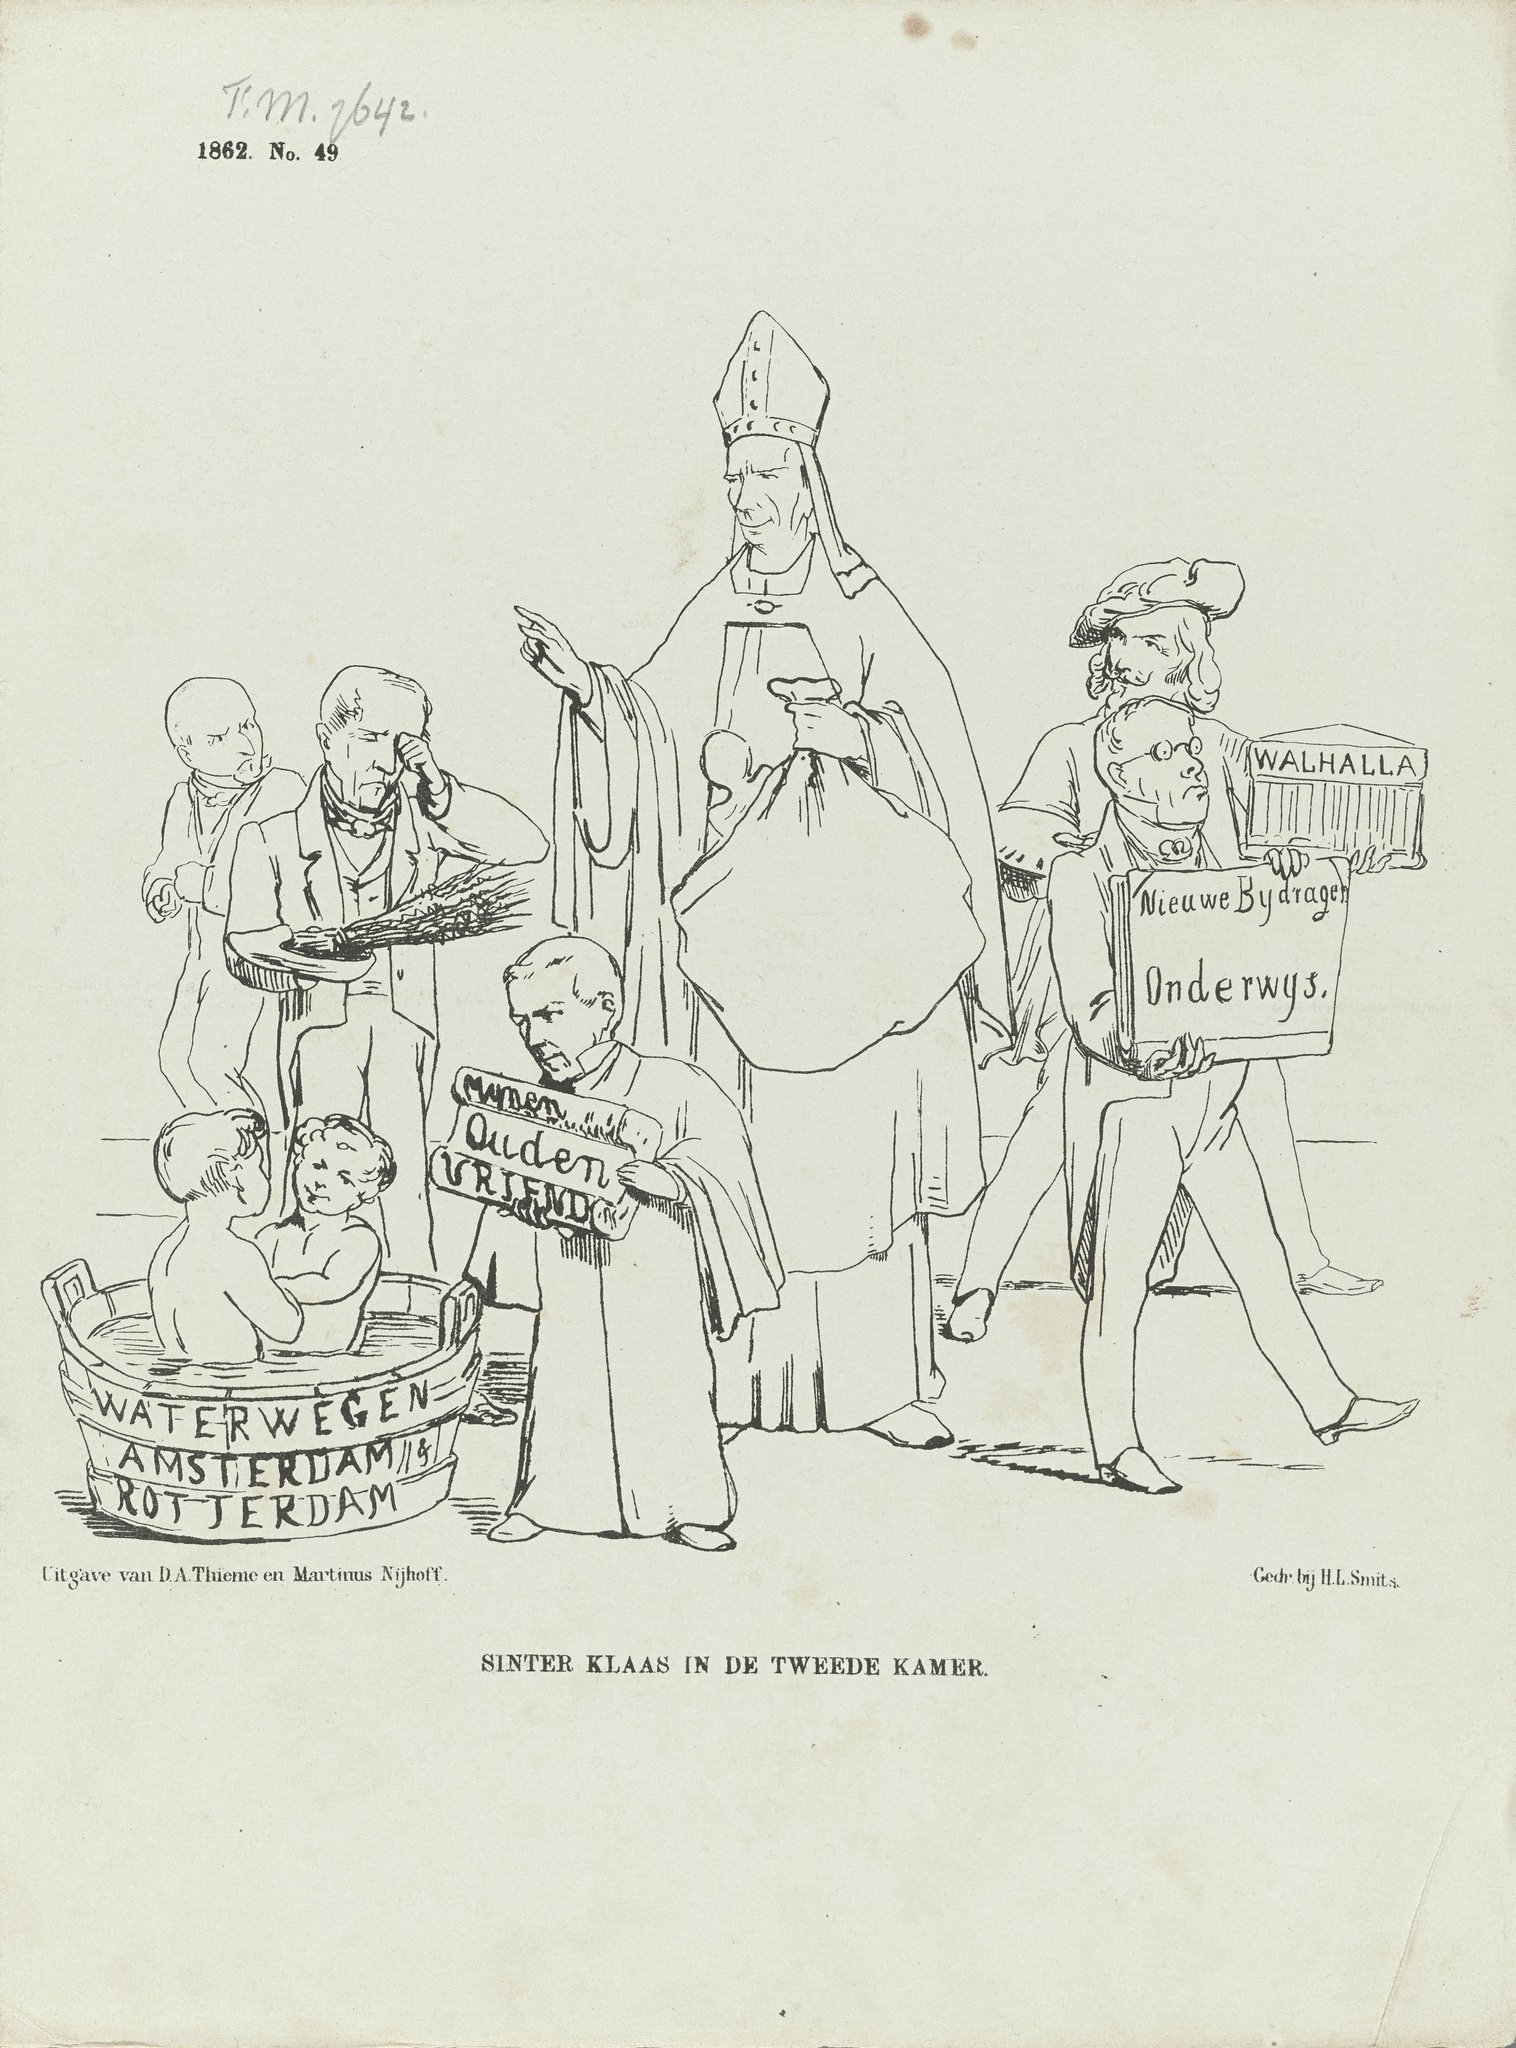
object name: print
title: Sinter Klaas in de Tweede Kamer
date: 1862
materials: paper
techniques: lithograph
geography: arnhem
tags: johan rudolf thorbecke, festivities on st. nicholas (eve) (december 5), bringing gifts; exchanging gifts, st. nicholas restores to life three children who had been murdered, dismembered, and salted down in a pickling tub by an inn-keeper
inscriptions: collector's mark: Lugt 2228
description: Spotprent met Thorbecke als Sinterklaas in de Tweede Kamer, sommigen krijgen cadeaus, andere een roe of niets. Plaat verschenen bij het weekblad De Nederlandsche Spectator, nr. 49, 6 december 1862.